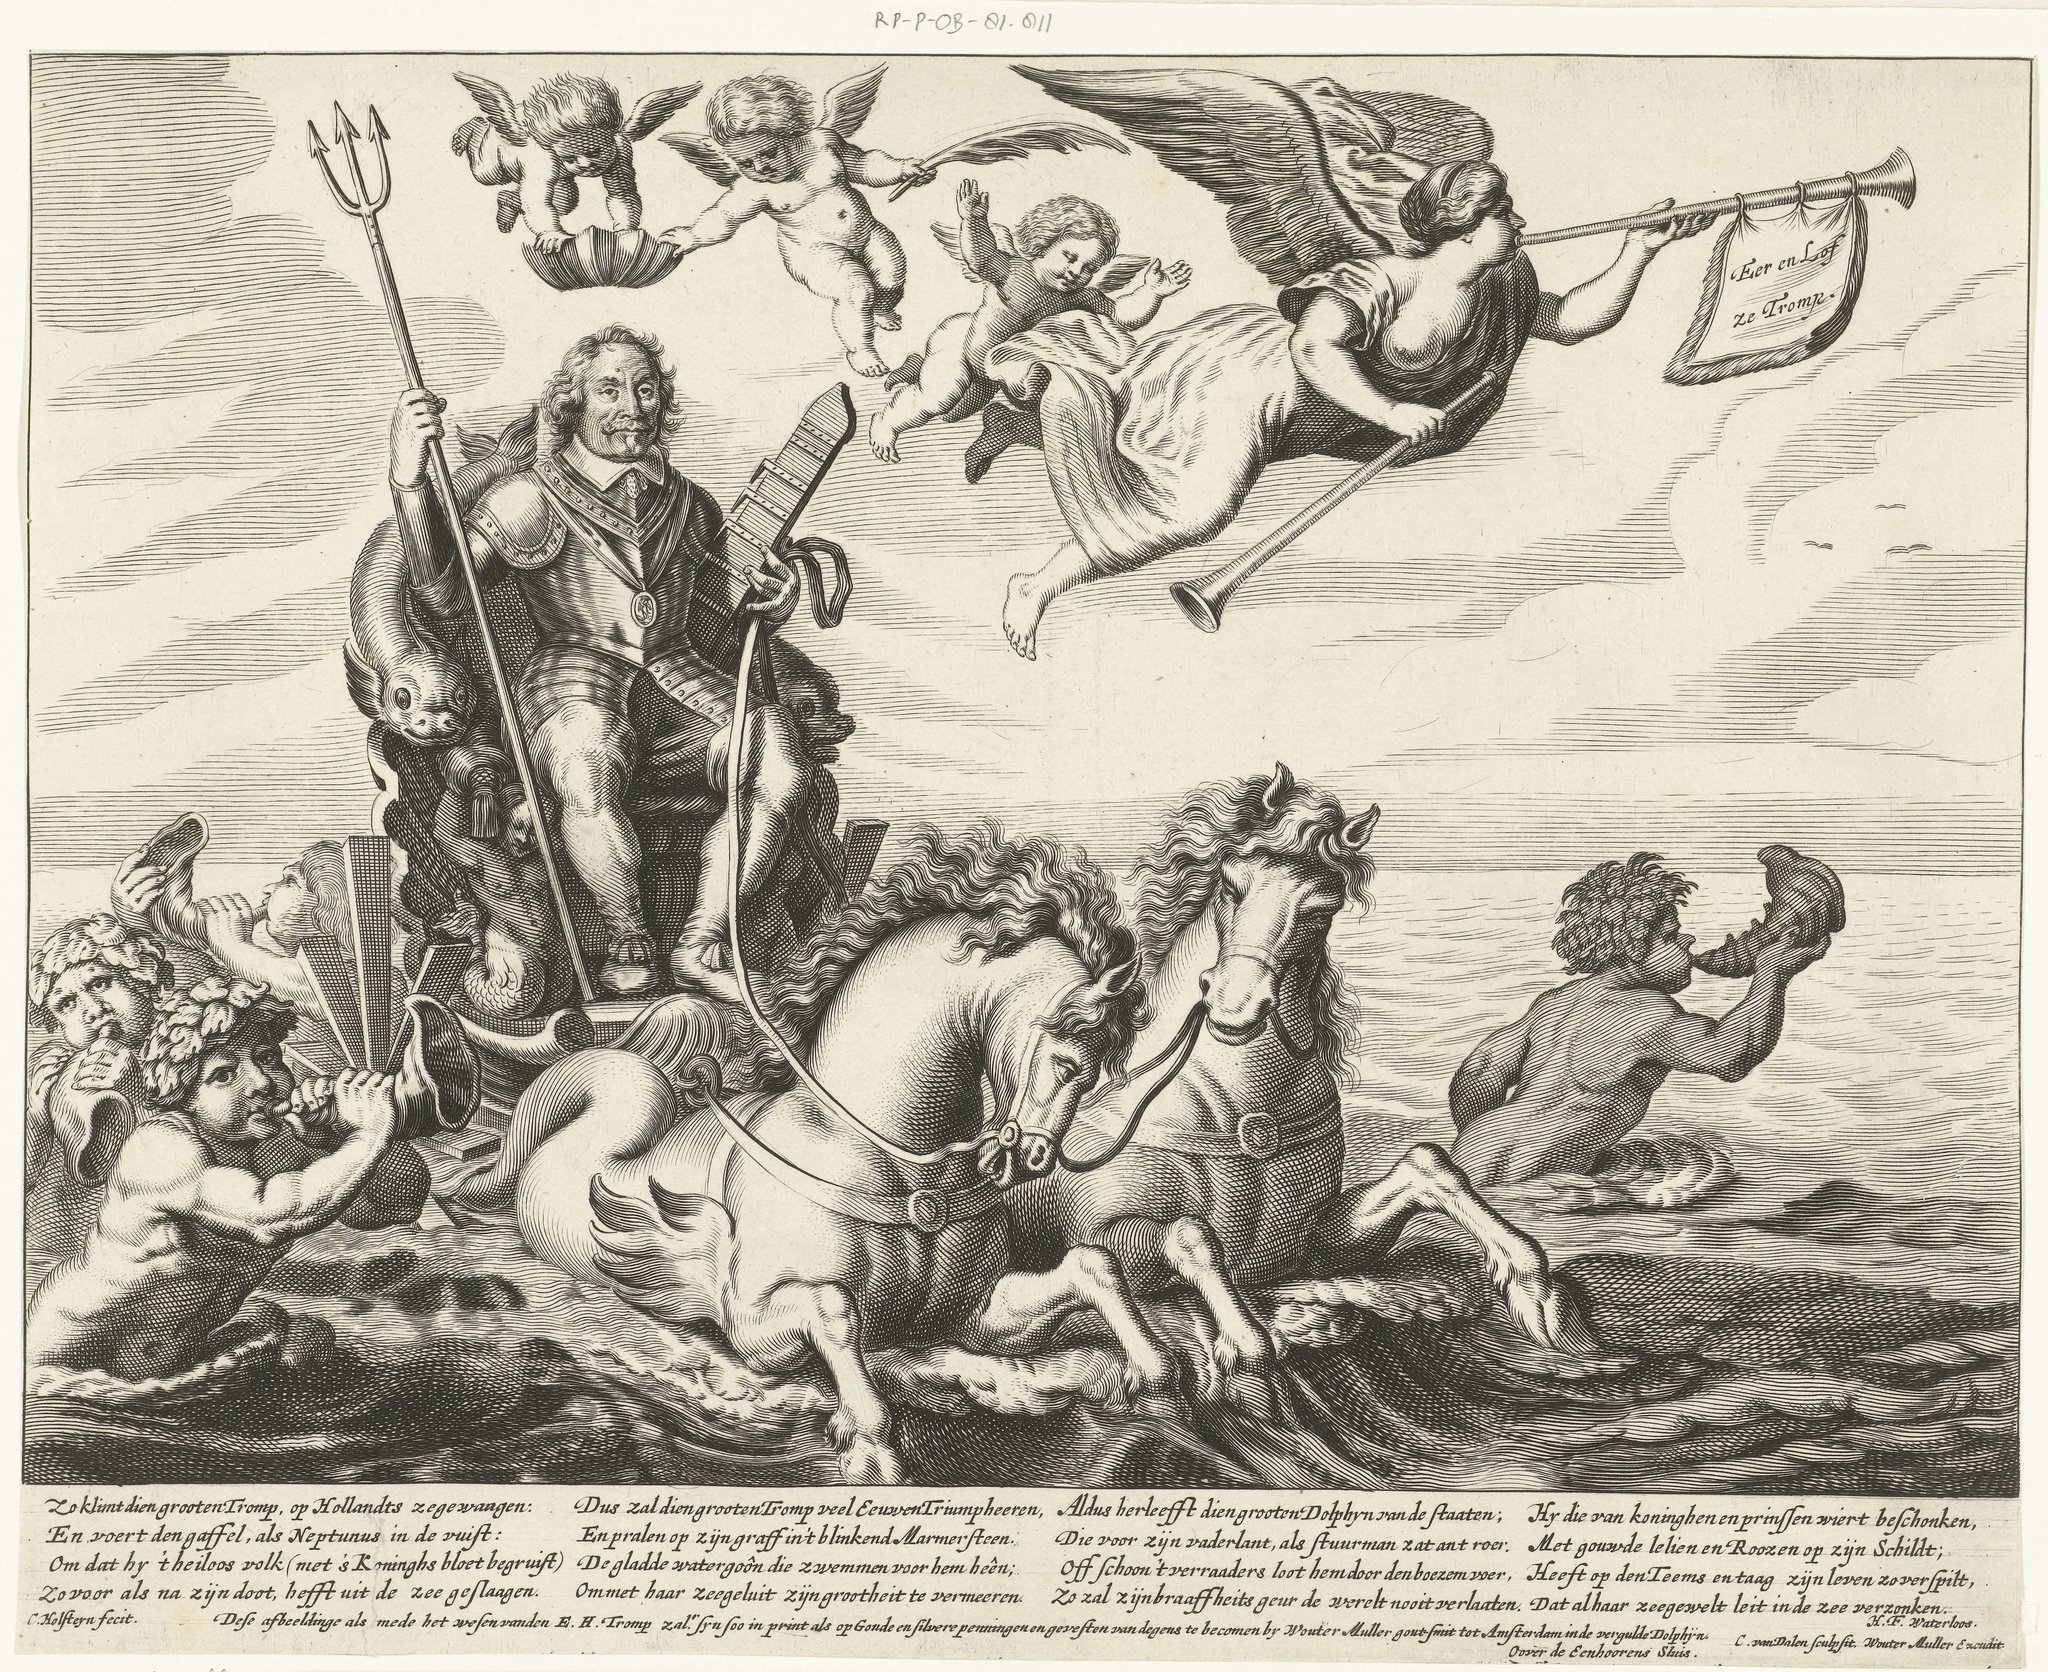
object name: print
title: Zegewagen ter ere van Maarten Tromp, gesneuveld in de Zeeslag bij Terheide, 1653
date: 1653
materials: paper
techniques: engraving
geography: northern netherlands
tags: brielle, maarten harpertszoon tromp, chariot, triumphal car, symbolic triumphs of individual persons, battle of scheveningen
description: Admiraal Maarten Tromp, gesneuveld in de zeeslag bij Terheide op 10 augustus 1653, rijdend in een zegewagen over zee getrokken door paarden en vergezeld door tritons. In zijn handen een drietand en een scheepsroer. In de lucht de Faam met twee bazuinen en drie engeltjes. Een engel kroont Tromp met een schepenkroon. In het onderschrift vier vierregelige verzen.